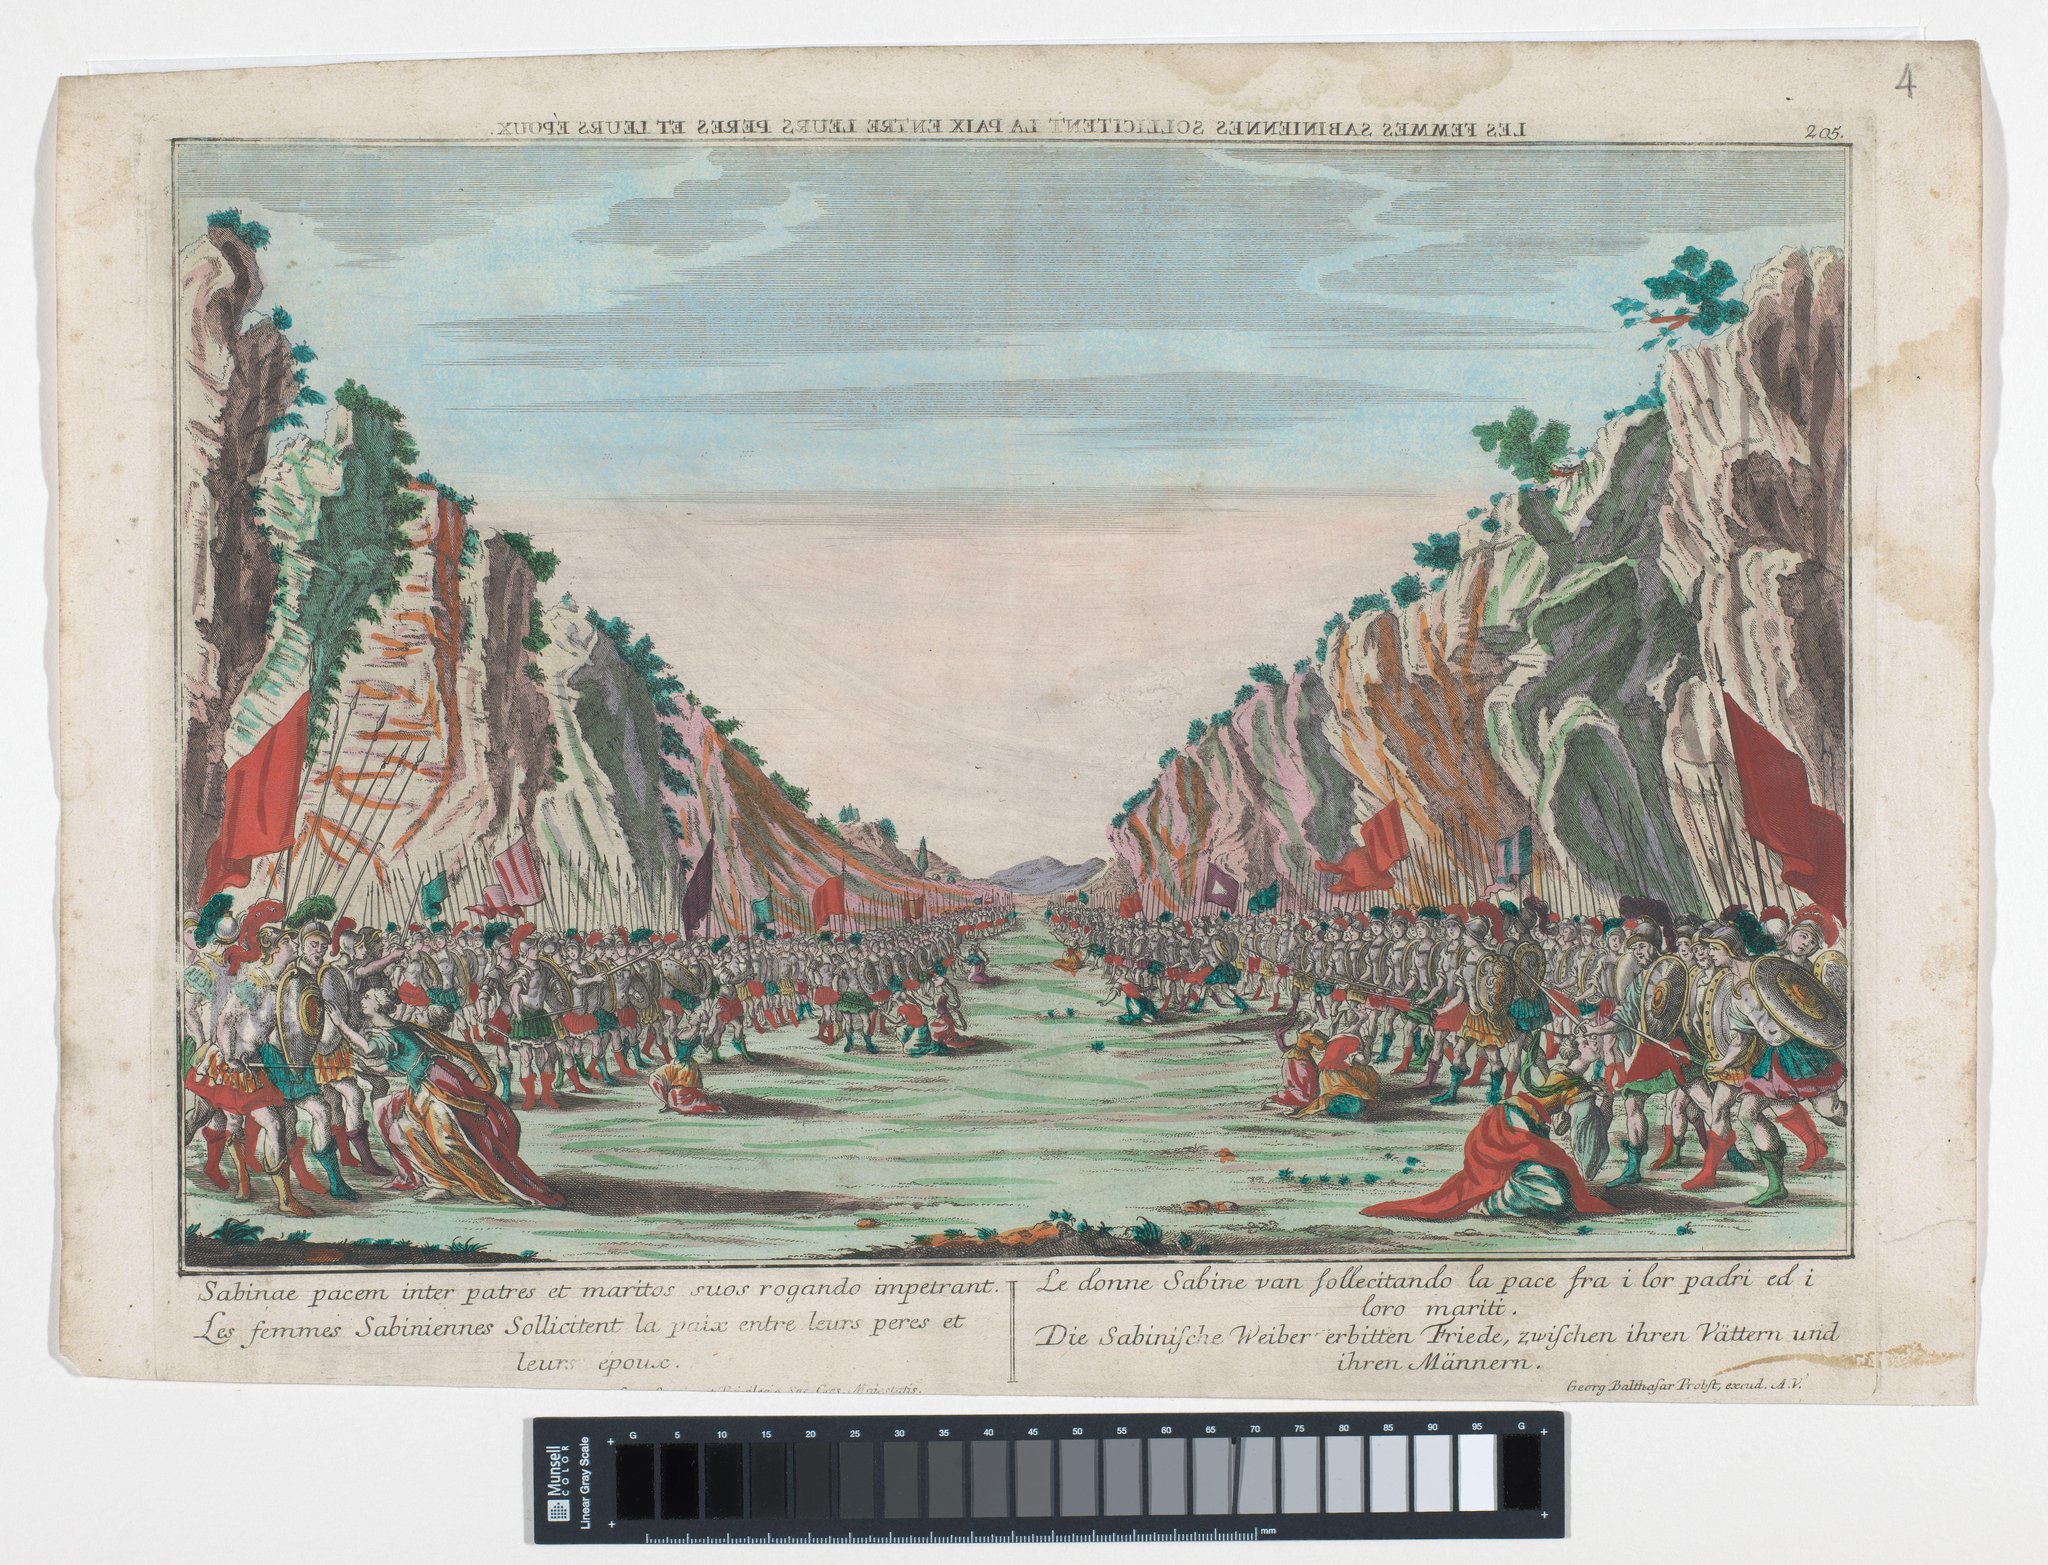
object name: print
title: Die Sabinische Weiber erbitten Friede, zwischen ihren Vättern und ihren Männern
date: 1742-1801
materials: paper, watercolor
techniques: brush, etching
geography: augsburg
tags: (story of) romulus and remus, reconciliation of the sabines and the romans: the women, some holding their babies, others with their hair loose, and possibly encouraged by hersilia call for peace in the midst of the two fighting armies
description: De moeders van de Sabijnse maagden werpen zich tussen de twee vechtende legers van Sabijnen en Romeinen en doen een oproep tot vrede. Rechtsboven genummerd: 205. Linksonder genummerd: 50.